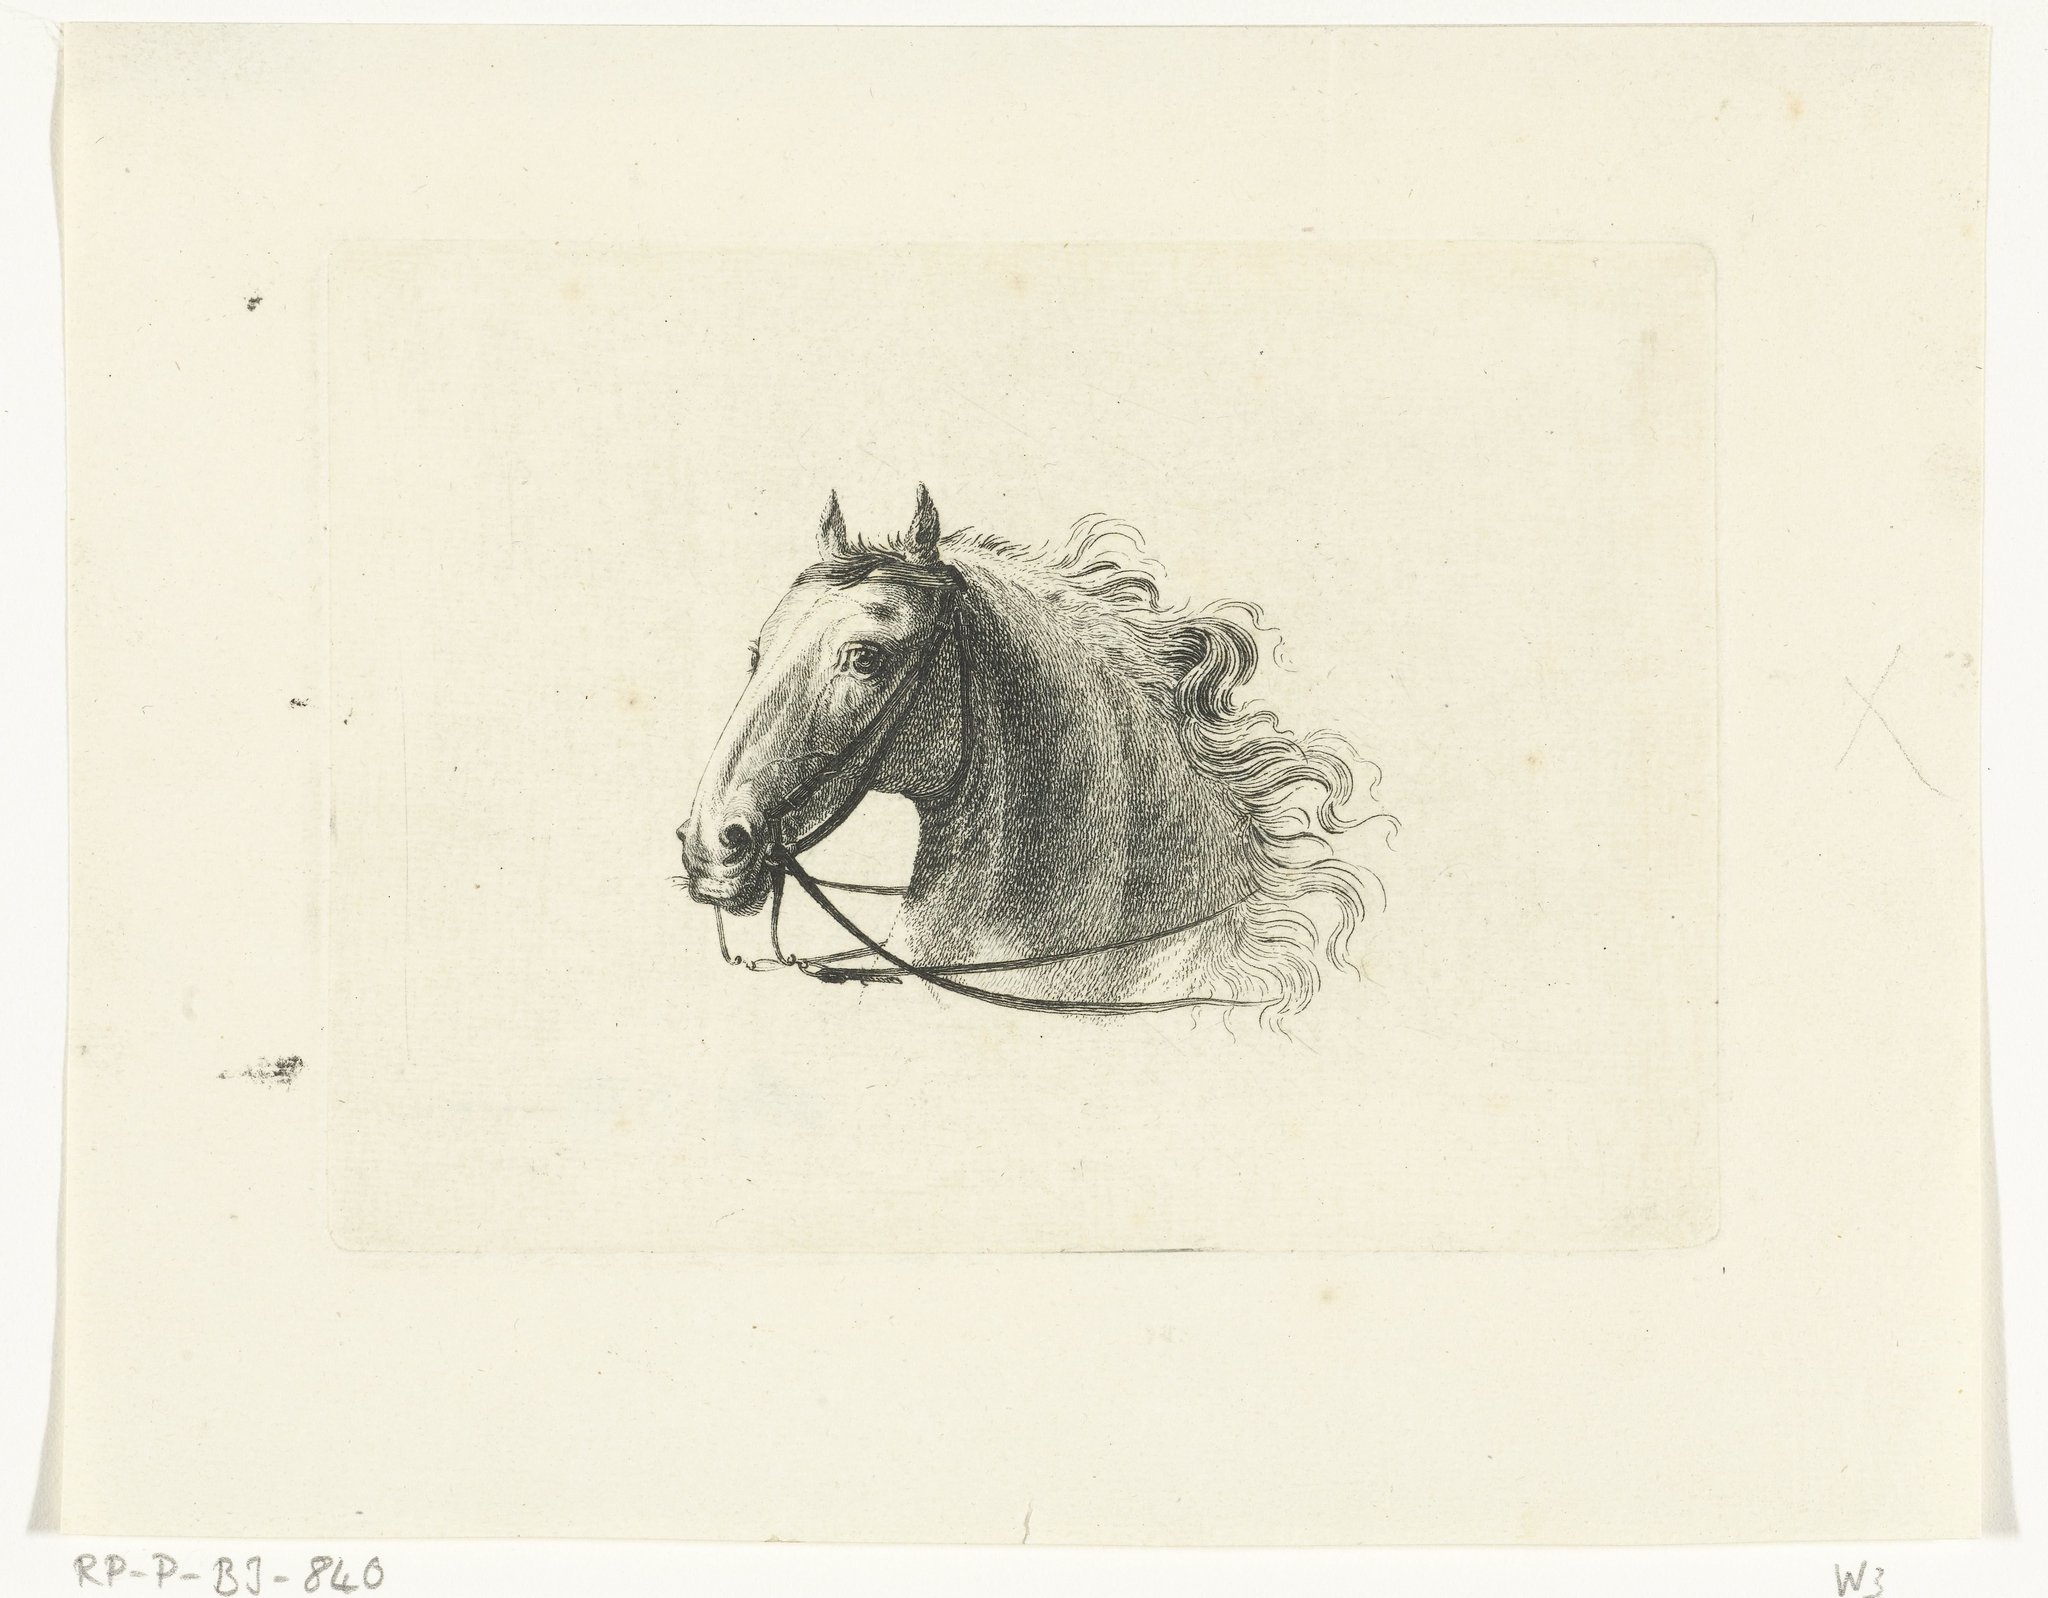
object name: print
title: Paardenhoofd, naar links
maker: joannes bemme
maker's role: print maker, printer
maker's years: 1775-1841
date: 1801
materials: paper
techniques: etching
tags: horse (+ head of an animal)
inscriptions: collector's mark: Lugt 2165